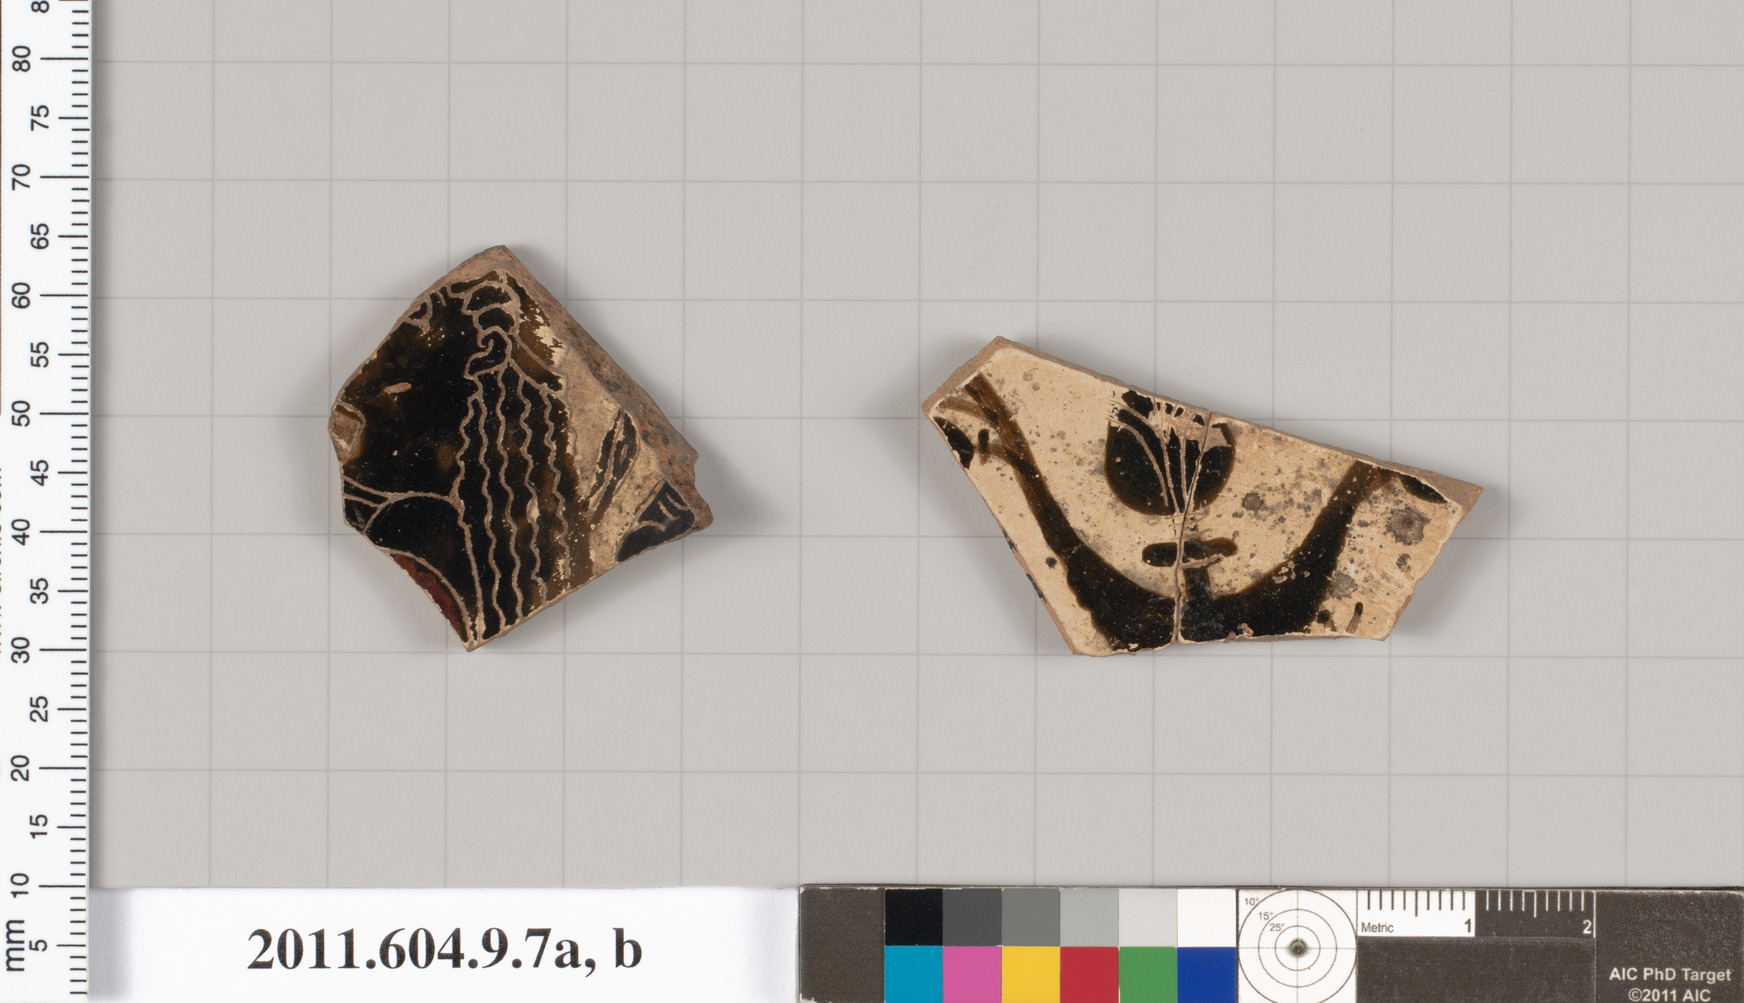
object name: kylix fragment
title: Terracotta fragment of a kylix (drinking cup)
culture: greek, laconian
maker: naukratis painter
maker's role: artist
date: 565-560 BCE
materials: terracotta